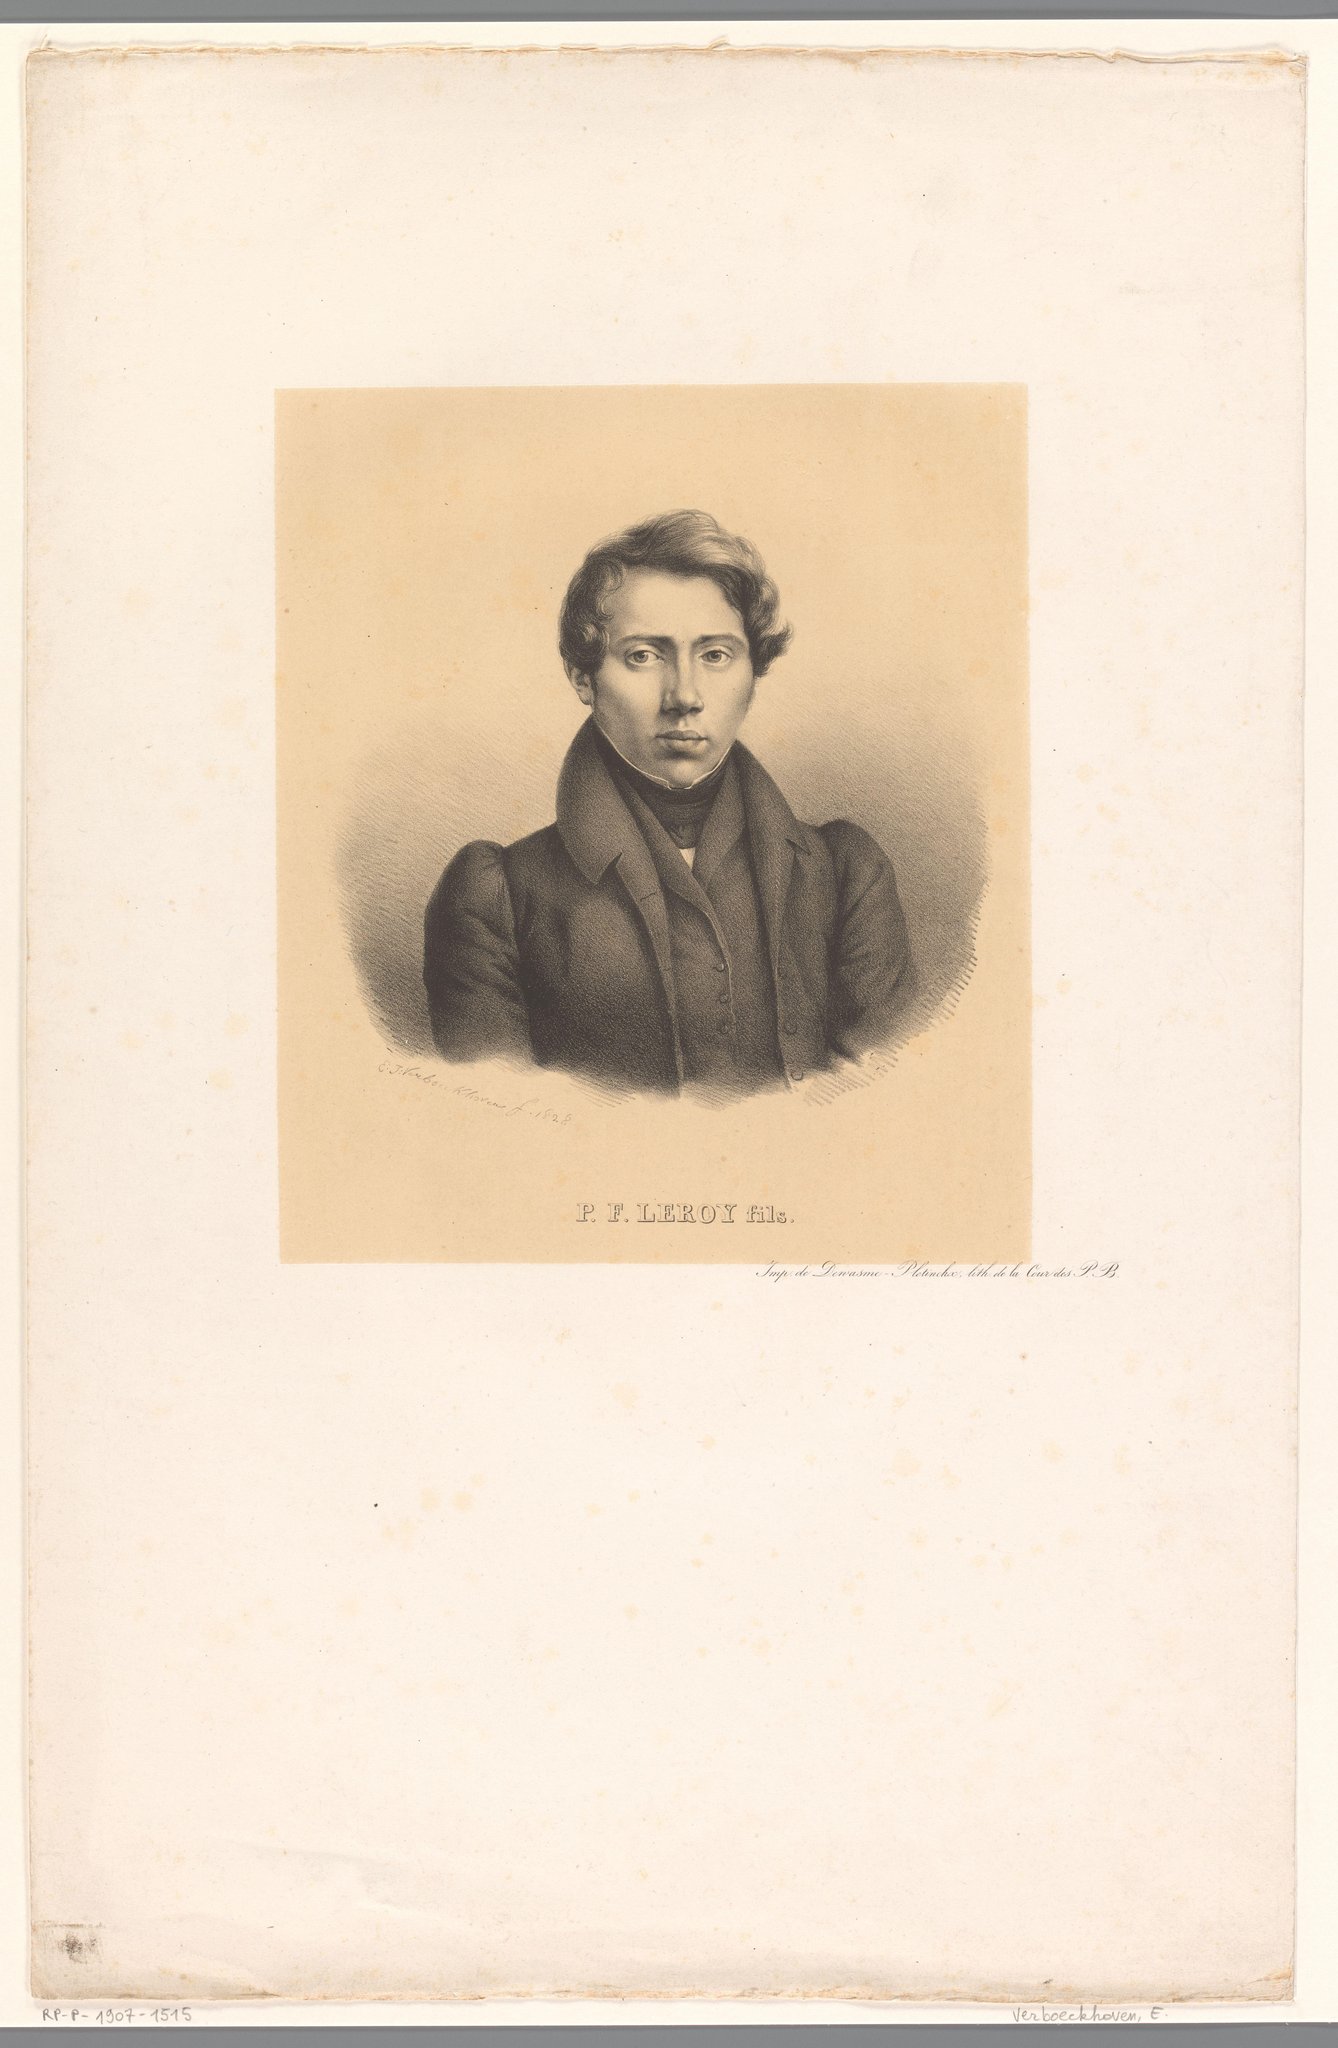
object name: print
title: P.F. Leroy fils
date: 1828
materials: paper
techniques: tone lithography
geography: brussels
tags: brussels, painter, print maker, draughtsman, pierre-françois le roy, historical persons, portrait, self-portrait of painter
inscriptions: collector's mark: Lugt 2228